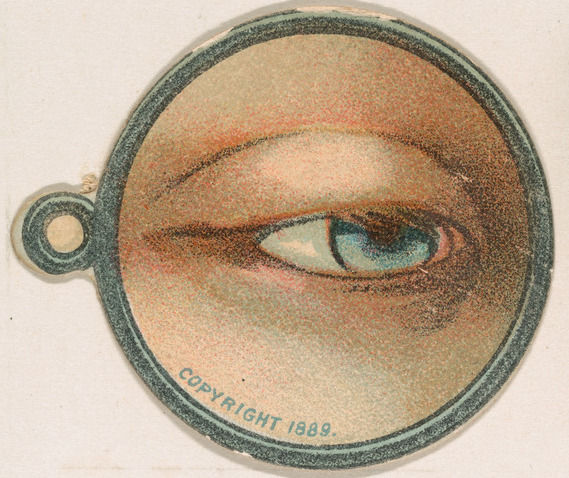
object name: print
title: Monocle and Eye (blue), from Jocular Ocular series (N221) issued by Kinney Bros.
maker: kinney brothers tobacco company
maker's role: publisher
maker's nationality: american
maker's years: 1869-2011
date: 1889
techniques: color lithograph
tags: eyes